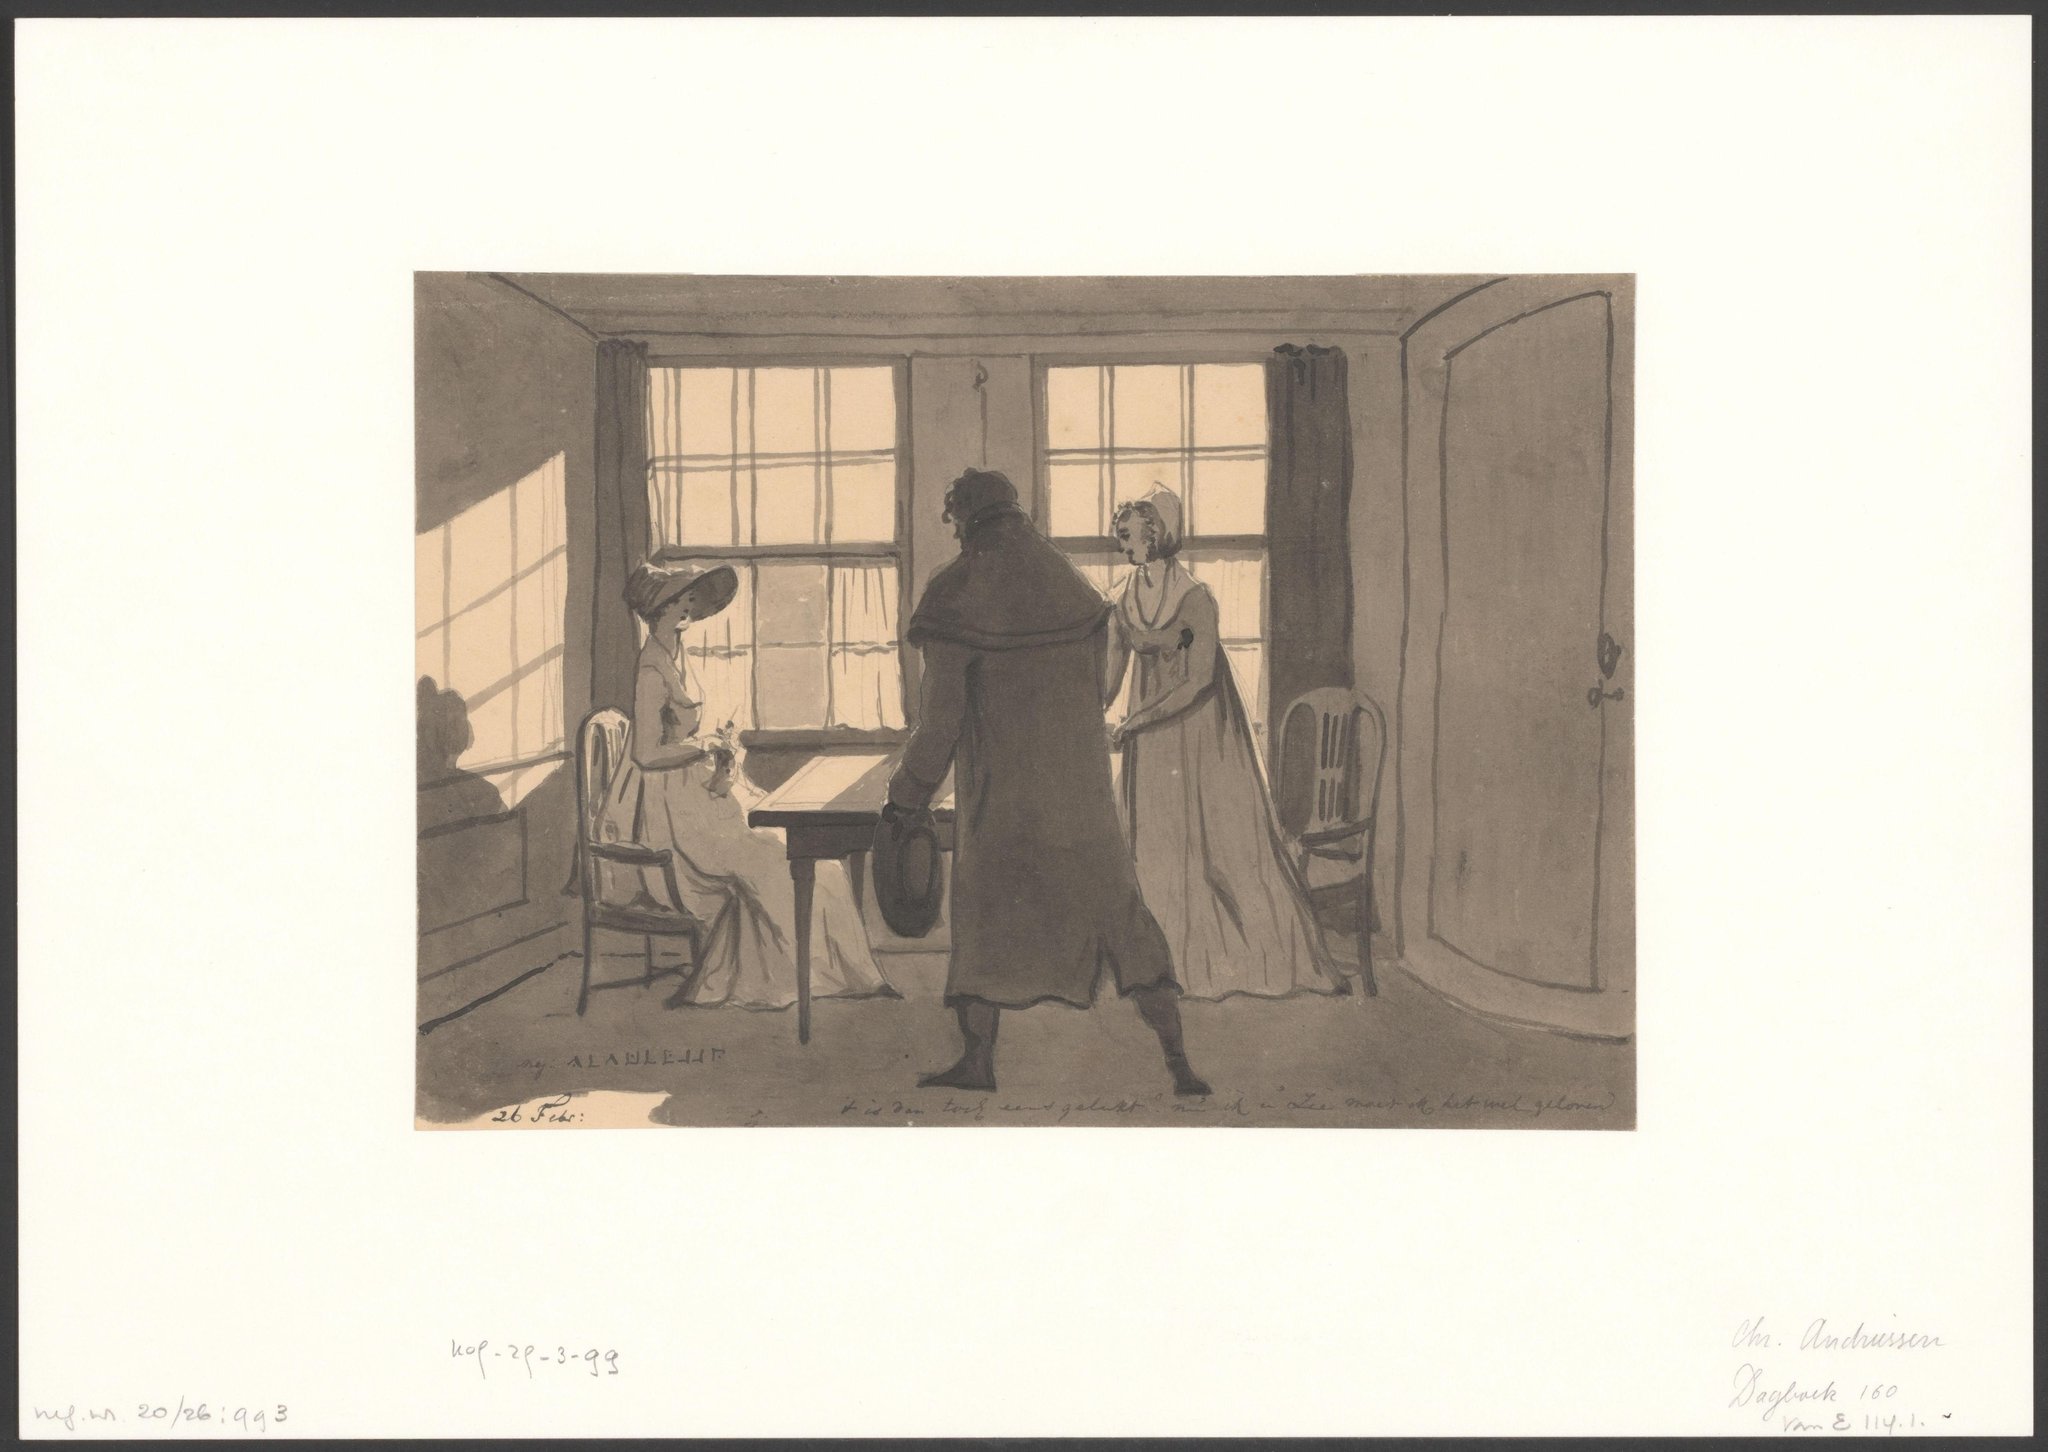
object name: drawing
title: Christiaan Andriessen brengt onverwacht een bezoek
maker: christiaan andriessen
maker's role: draughtsman, print maker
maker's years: 1775-1846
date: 1805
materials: ink, paper, pencil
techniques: brush, pen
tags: standing figure, sitting figure - aa - female human figure, interior of the house, standing figure - aa - female human figure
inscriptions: collector's mark: Lugt 1641a, inscription: ‘26 Febr: 't is dan toch gelukt, nu ik u zie moet ik het geloven’, signature: ‘J Andriessen’, collector's mark: Lugt 1641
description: Dagboekblad uit het getekende dagboek dat Christiaan Andriessen bijhield van 1805 tot en met 1808.